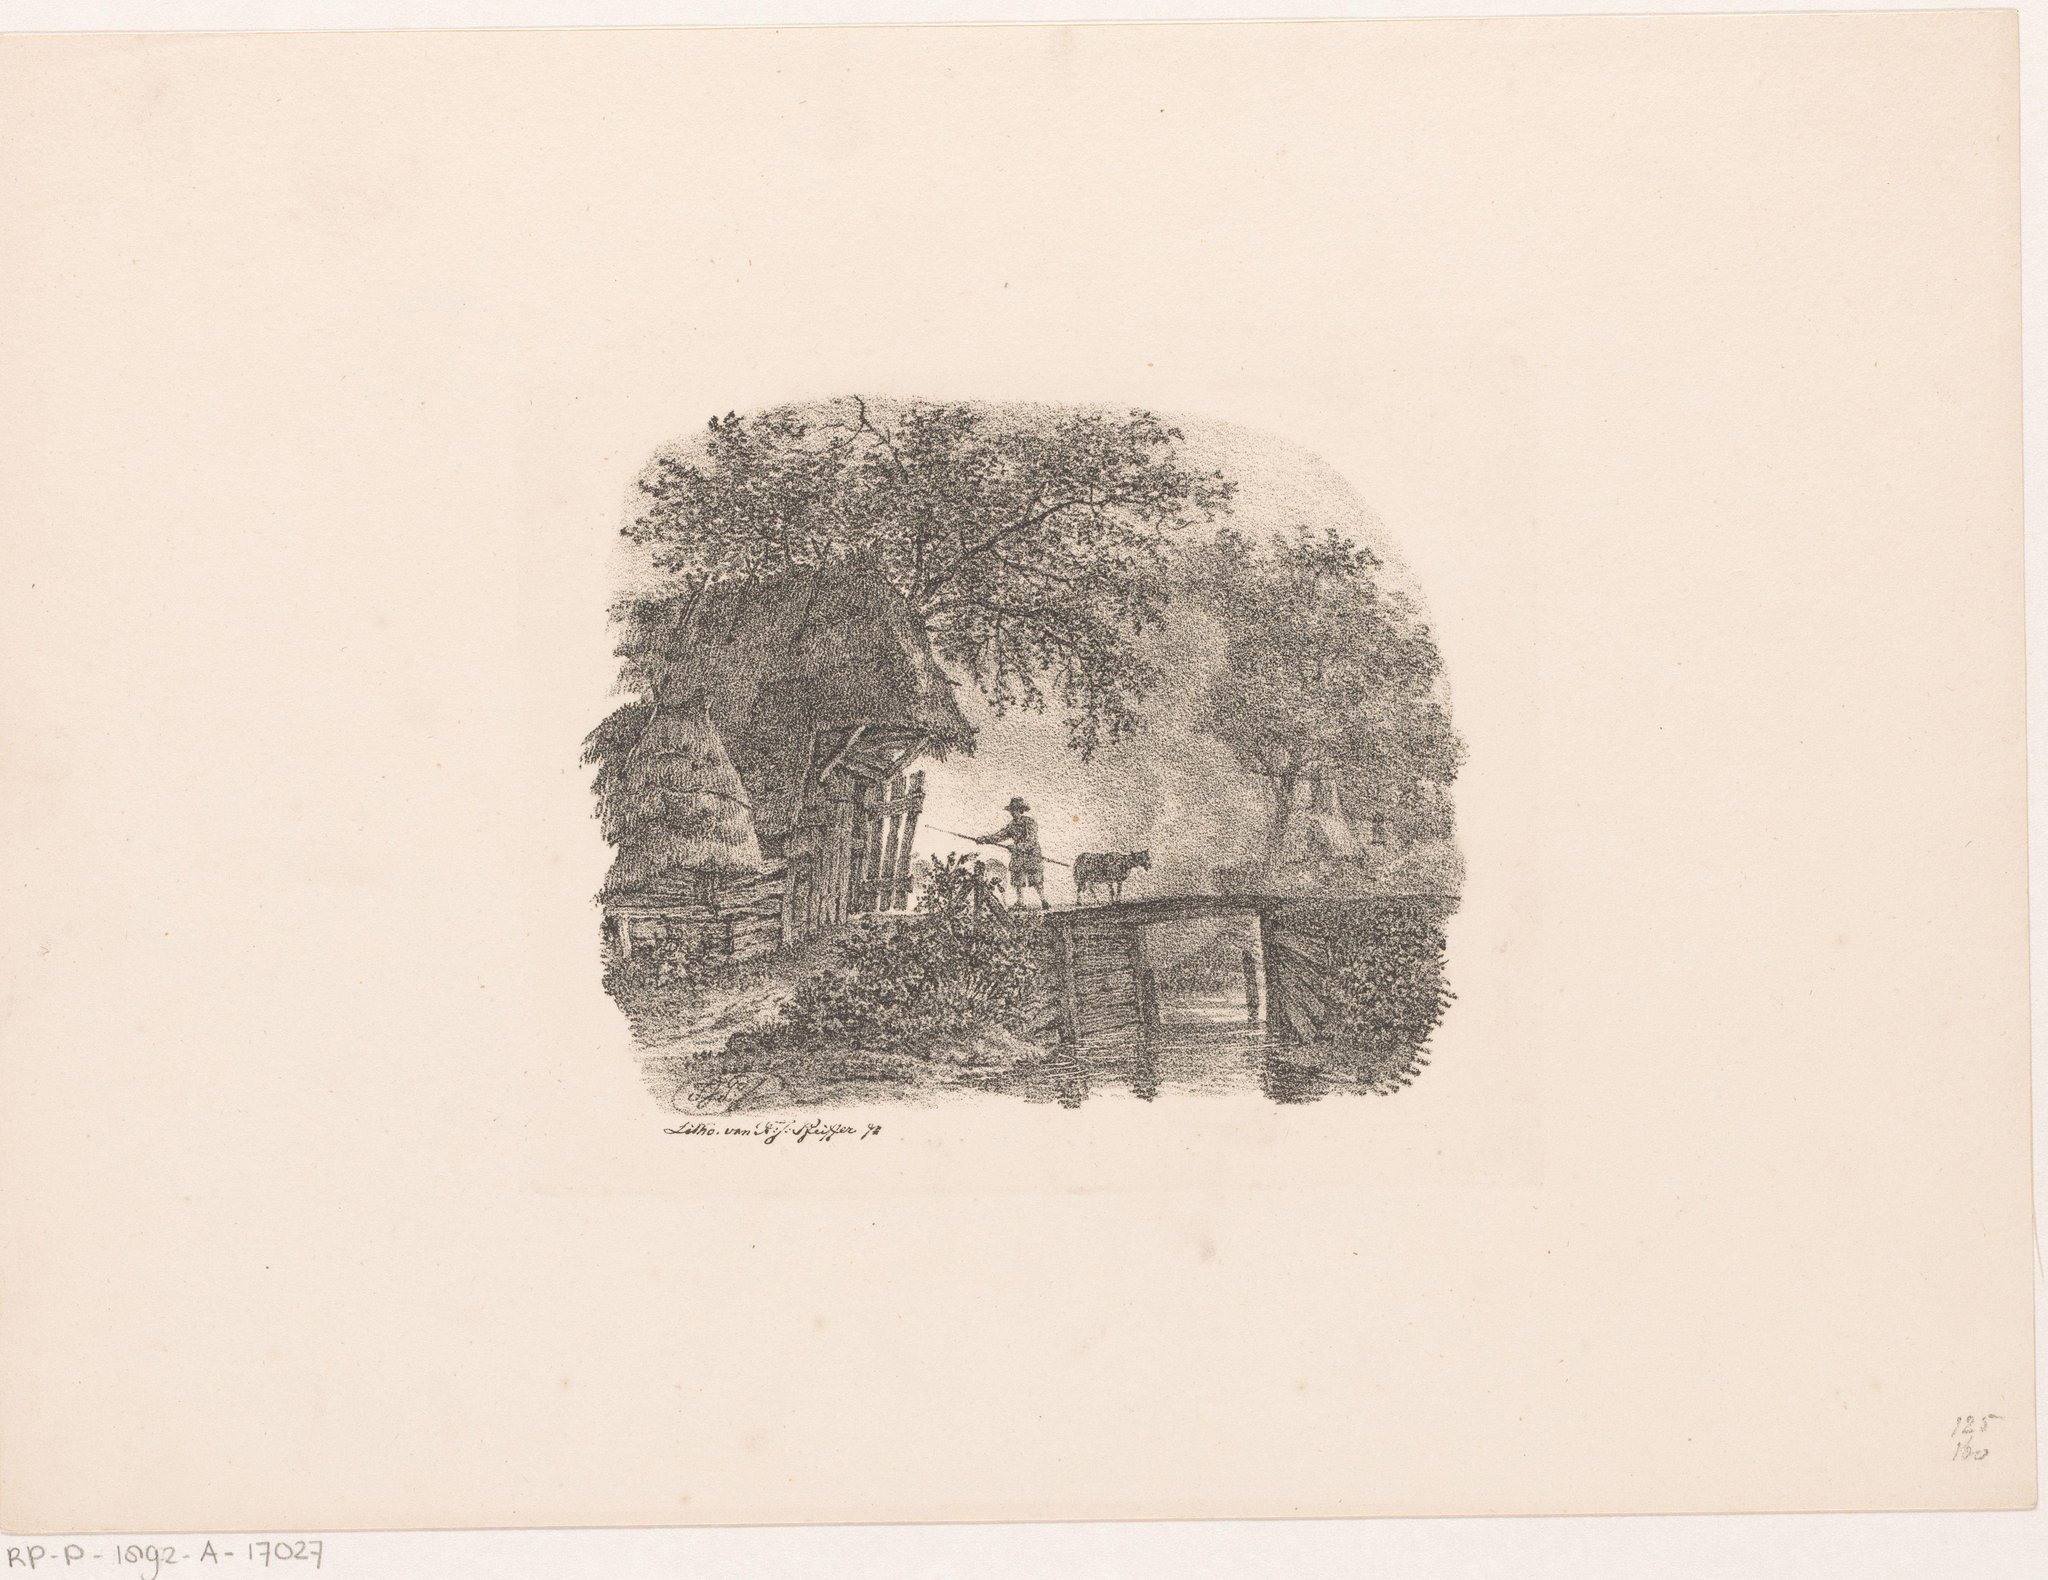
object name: print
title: Schaapskooi bij brug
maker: françois joseph pfeiffer (ii)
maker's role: draughtsman, print maker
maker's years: 1778-1835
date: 1809-1835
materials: paper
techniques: lithograph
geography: amsterdam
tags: herding, herdsman, herdswoman, shepherd, shepherdess, cowherd, etc., sheep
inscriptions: collector's mark: Lugt 2228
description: Op een brug loopt een man die een schaap drijft. Links een schaapskooi.